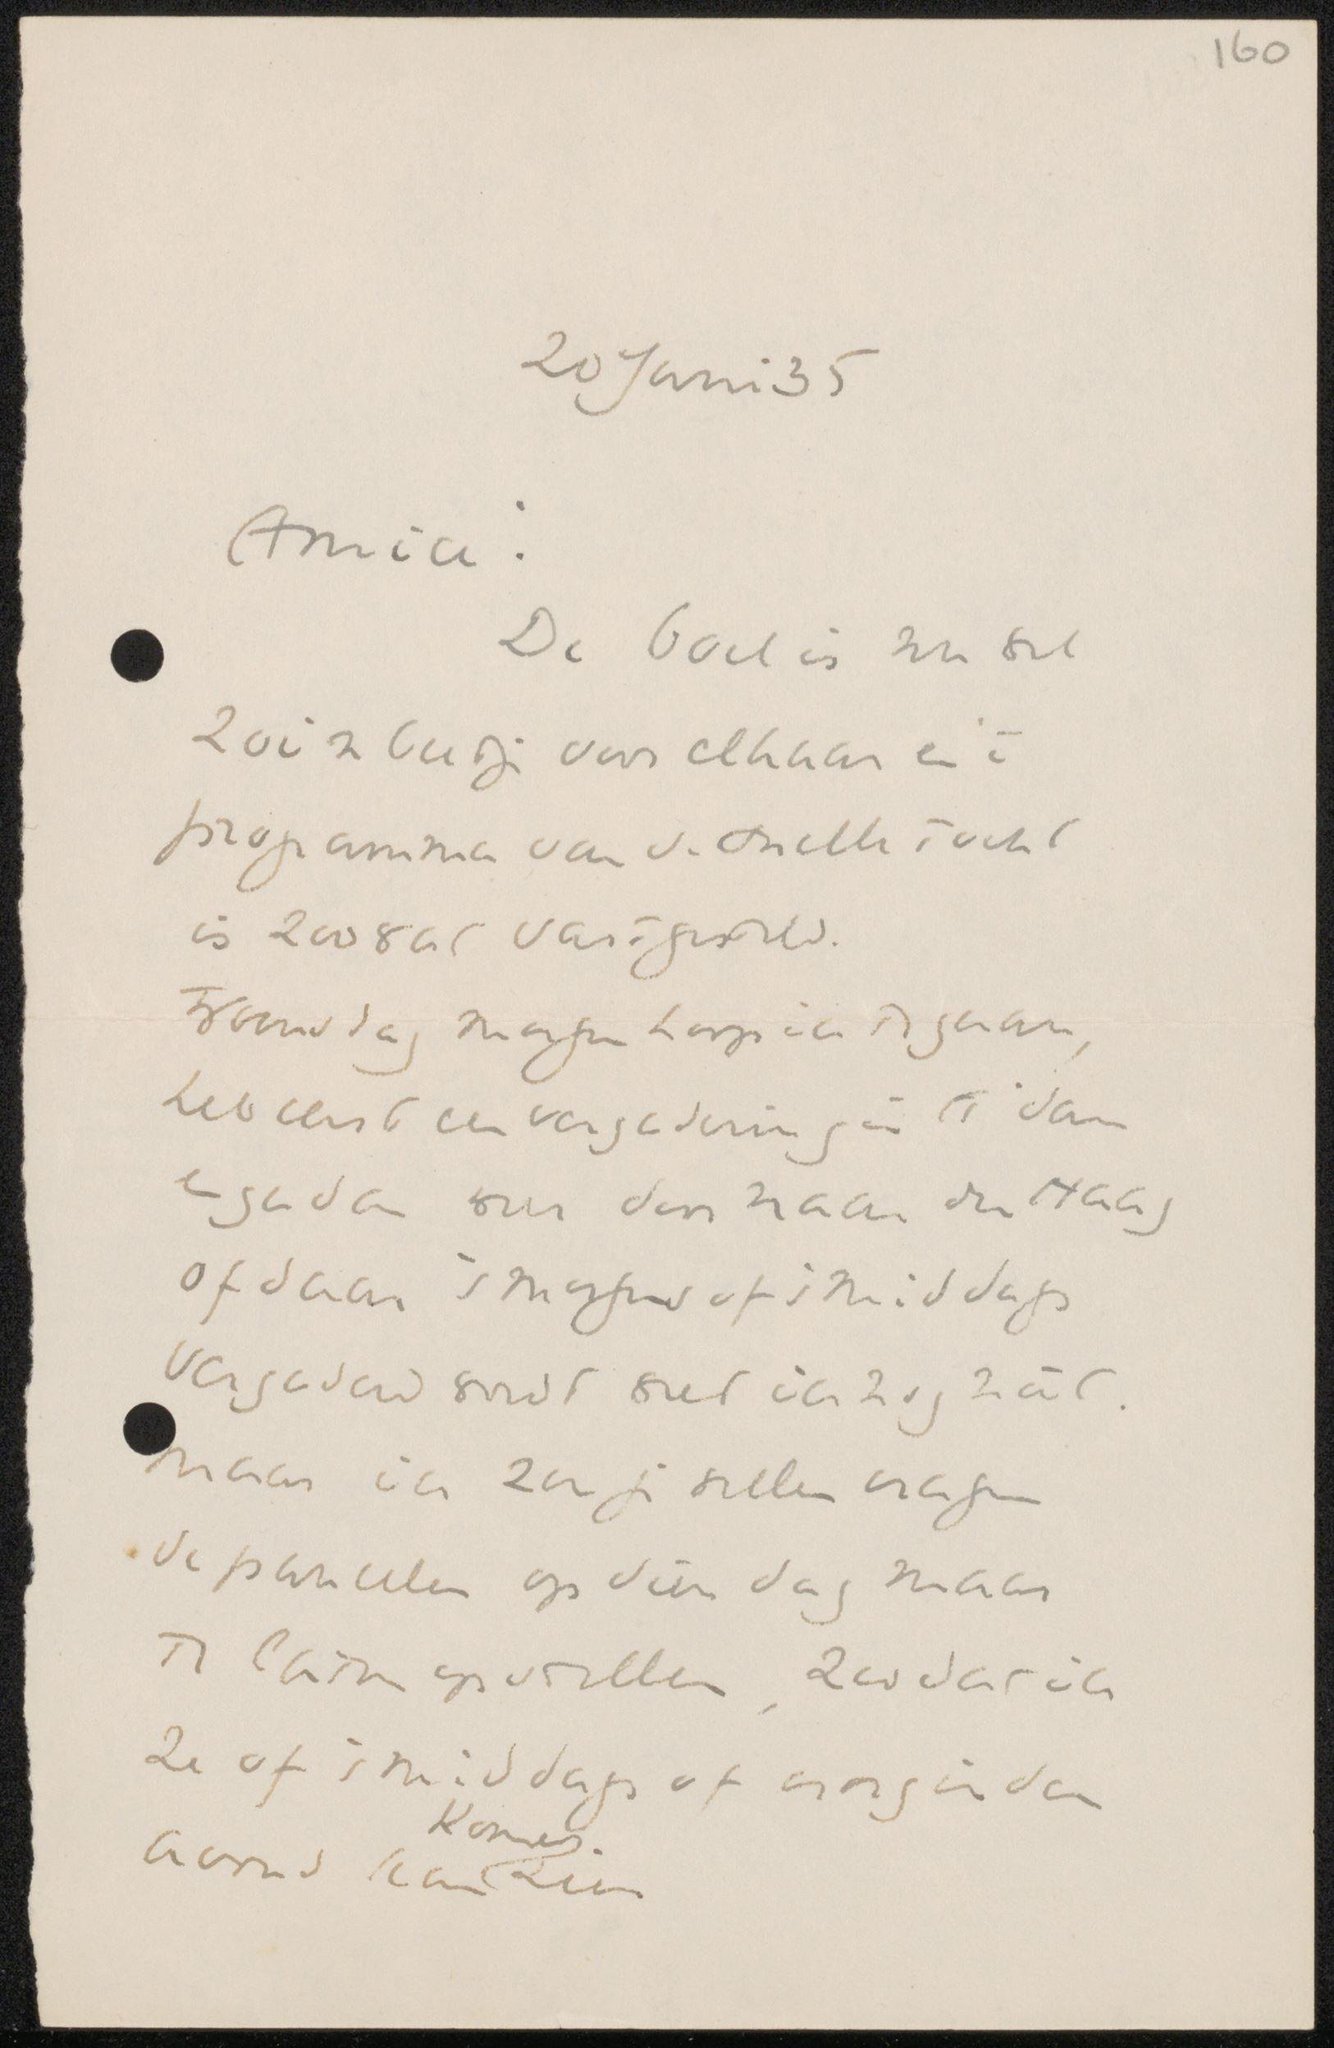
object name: letter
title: Brief aan Willem Bogtman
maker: richard nicolaüs roland holst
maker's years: 1868-1938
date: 1935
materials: ink, paper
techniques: pen, writing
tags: haarlem, willem bogtman, henriëtte roland holst-van der schalk, applied arts, arts and crafts; industrial design, the hague, amsterdam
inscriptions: watermark